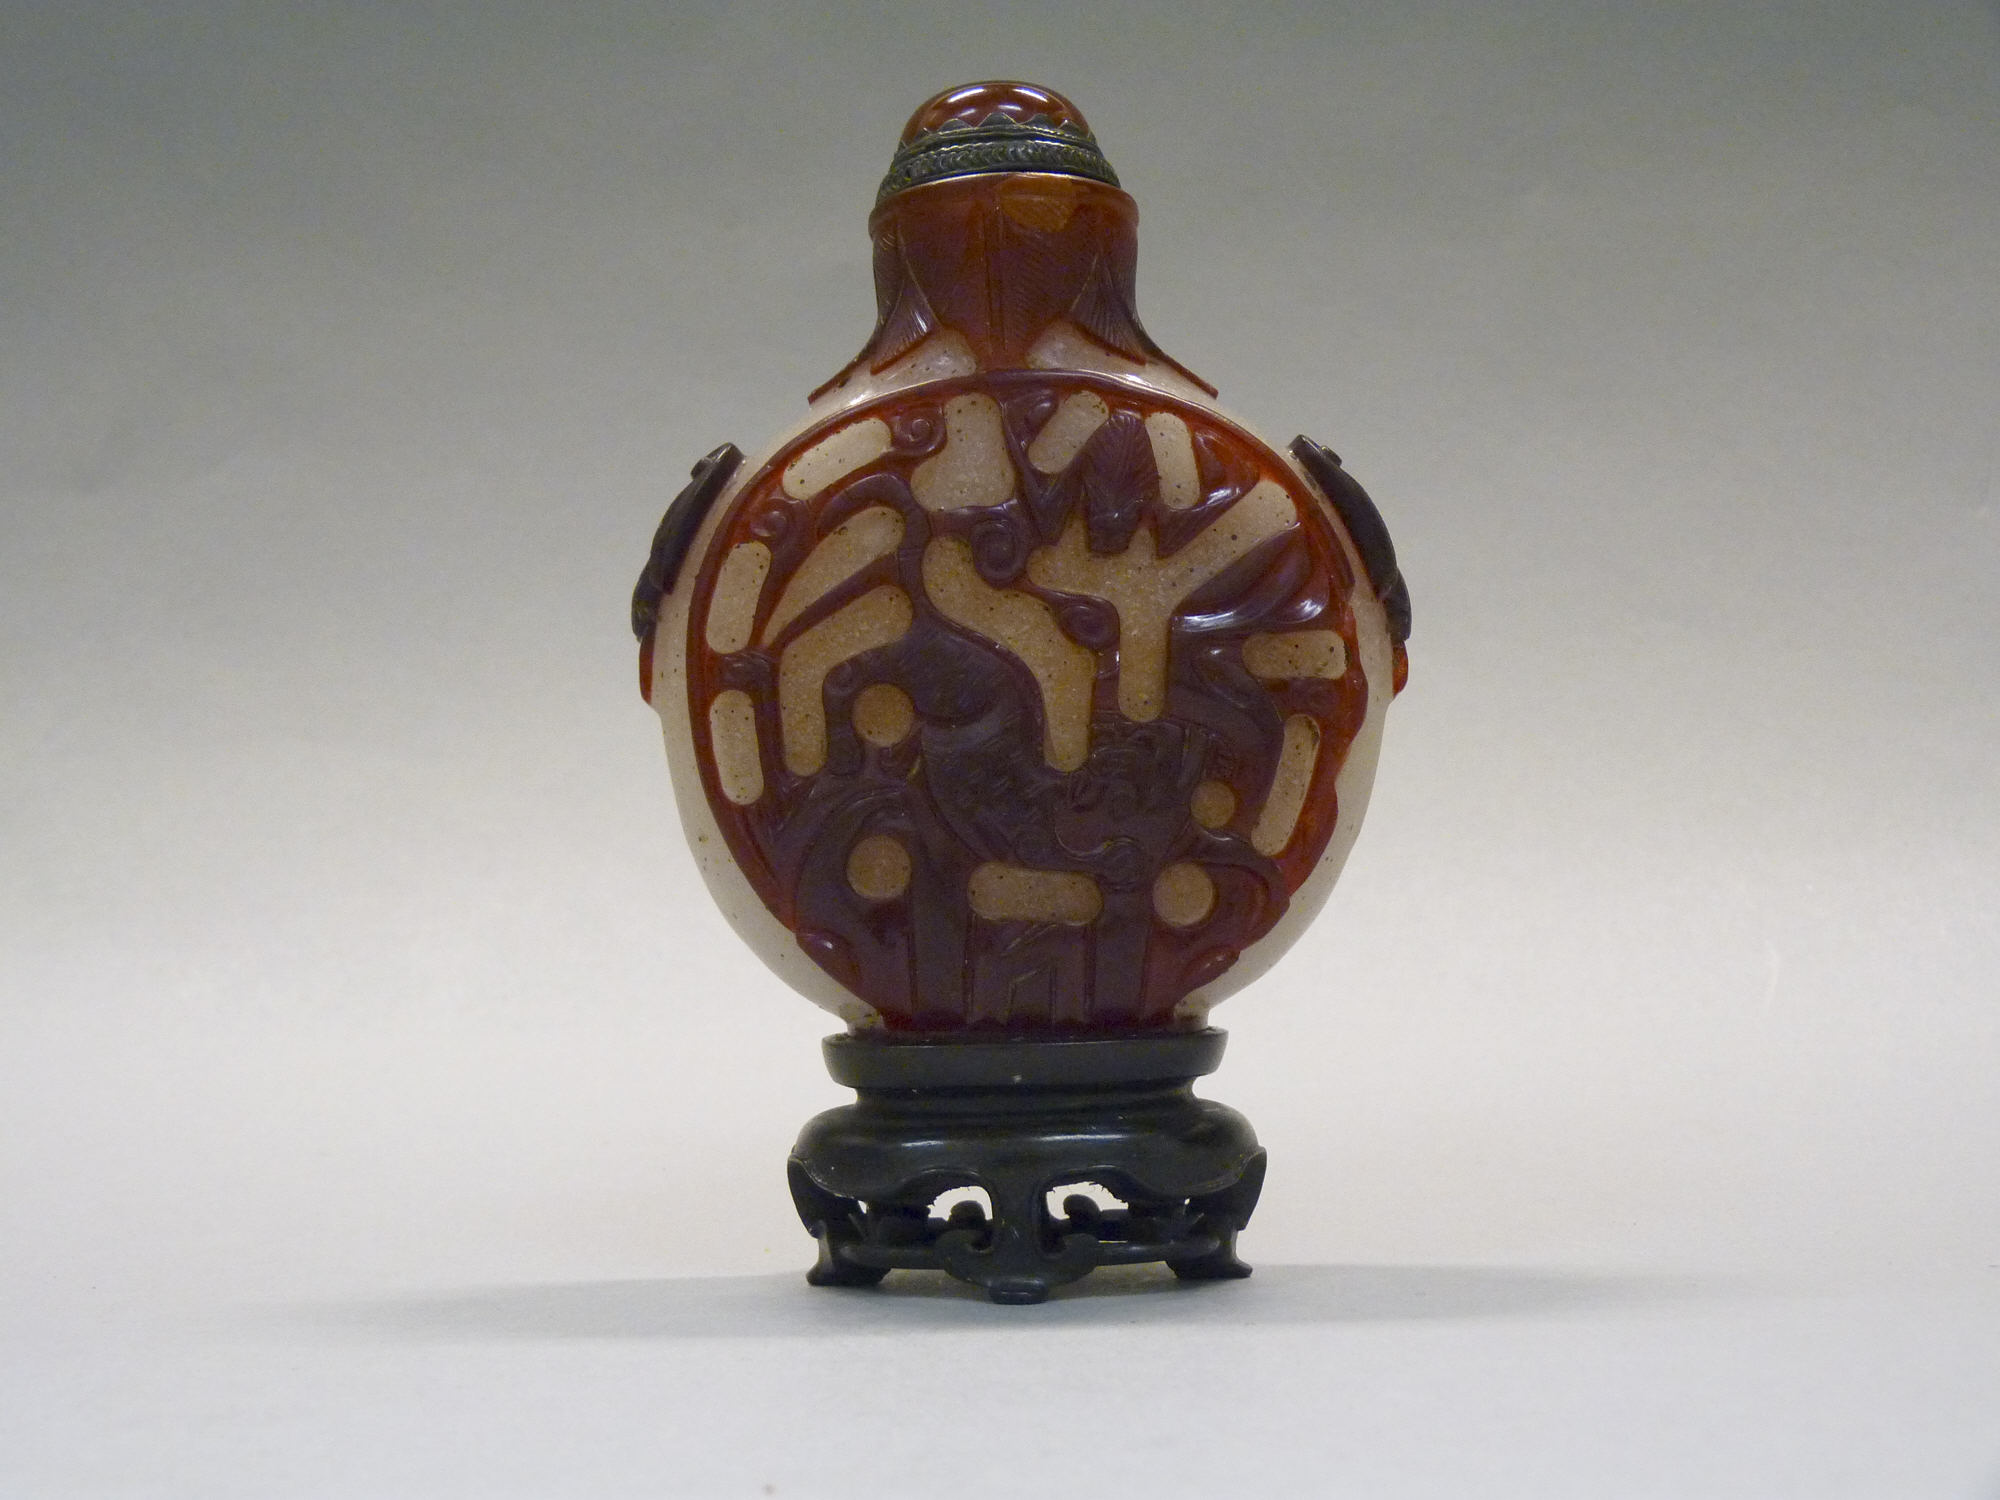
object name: snuff bottle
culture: chinese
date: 1736-1795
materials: amber, glass